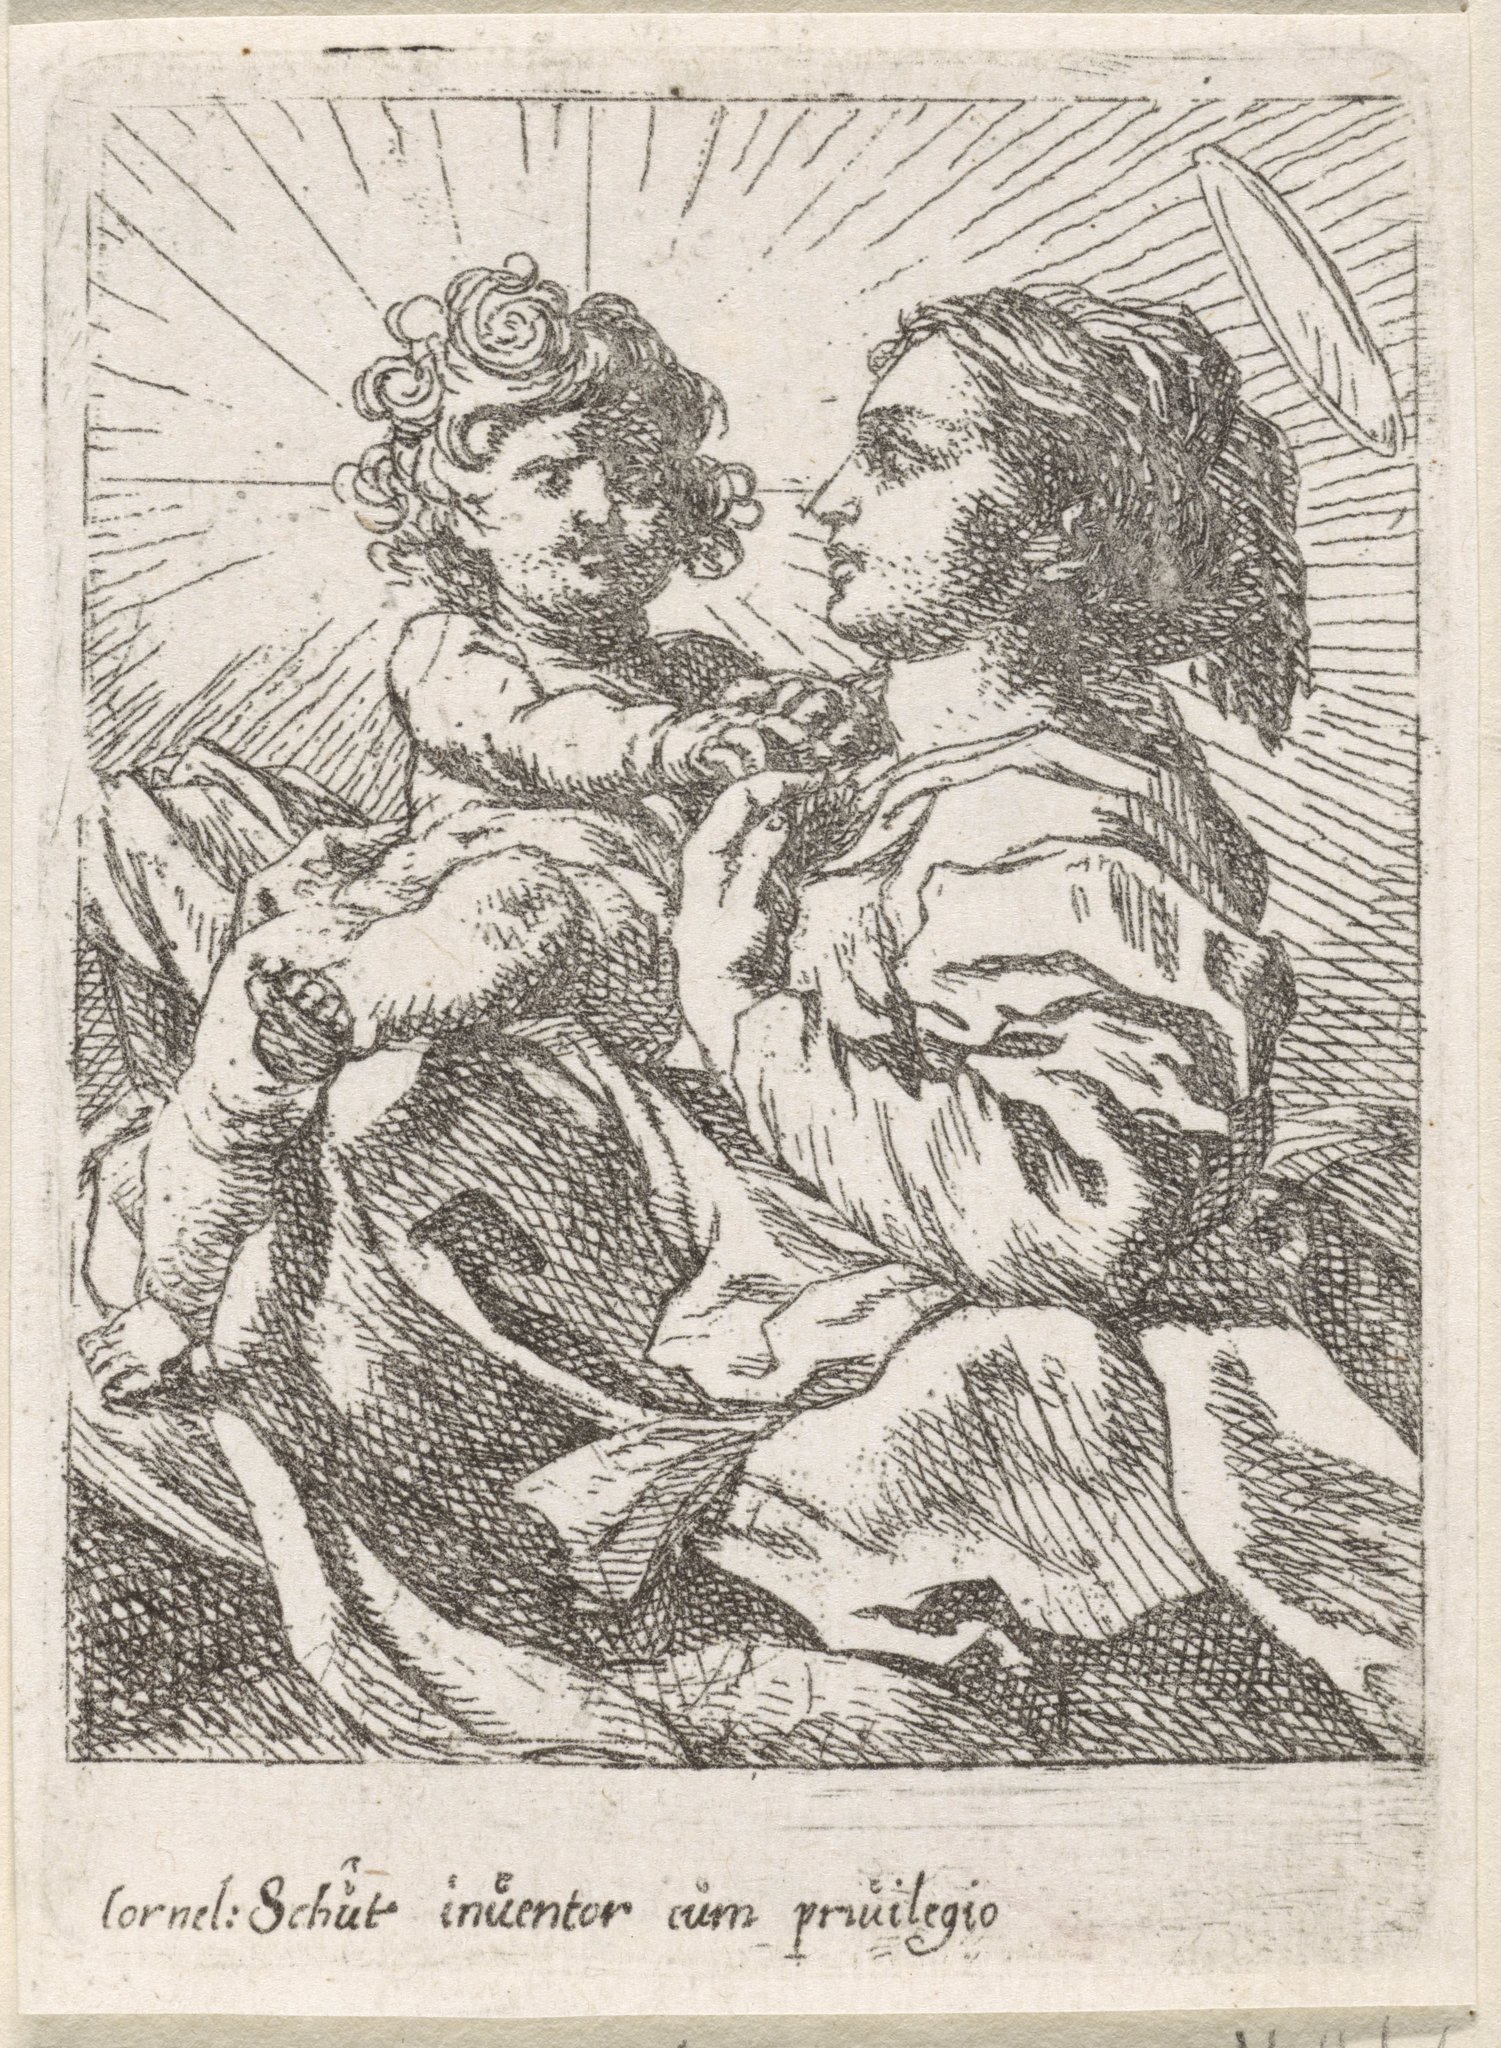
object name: print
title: Madonna met kind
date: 1618-1655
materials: paper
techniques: etching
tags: madonna: mary sitting or enthroned, the christ-child in her lap (or in front of her bosom) (mary sometimes represented half-length)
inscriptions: collector's mark: Lugt 240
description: Het Christuskind zit op de hoog opgetrokken knieën van Maria en houdt zijn handen bij haar hals.